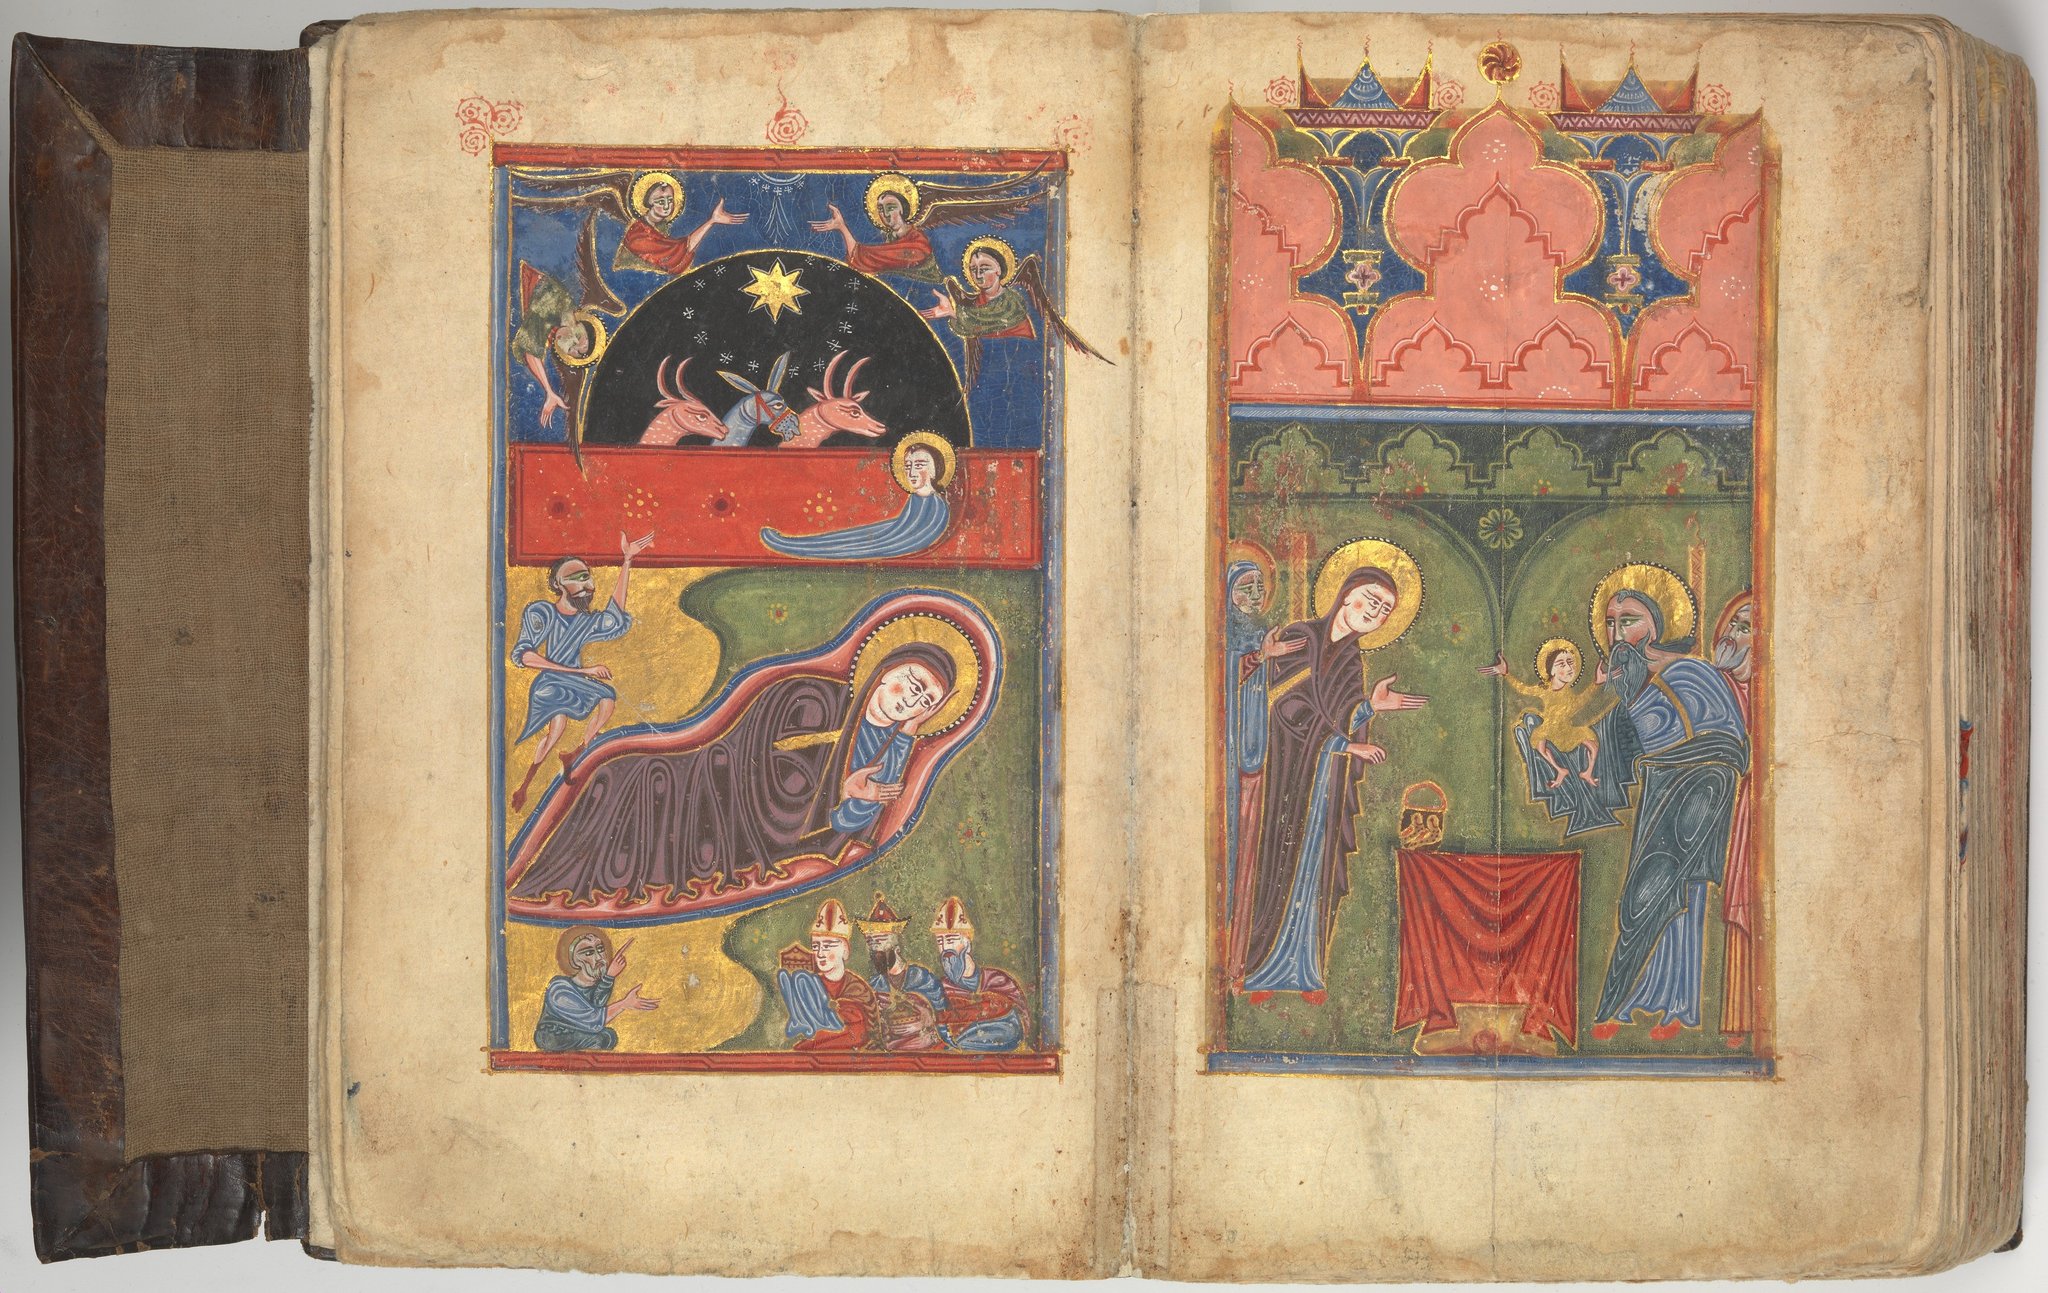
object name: gospel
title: Four Gospels in Armenian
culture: armenian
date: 1434-1435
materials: gold, leather, paper, paint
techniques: bookbinding, stamping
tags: men,angels,christ,virgin mary,nativity